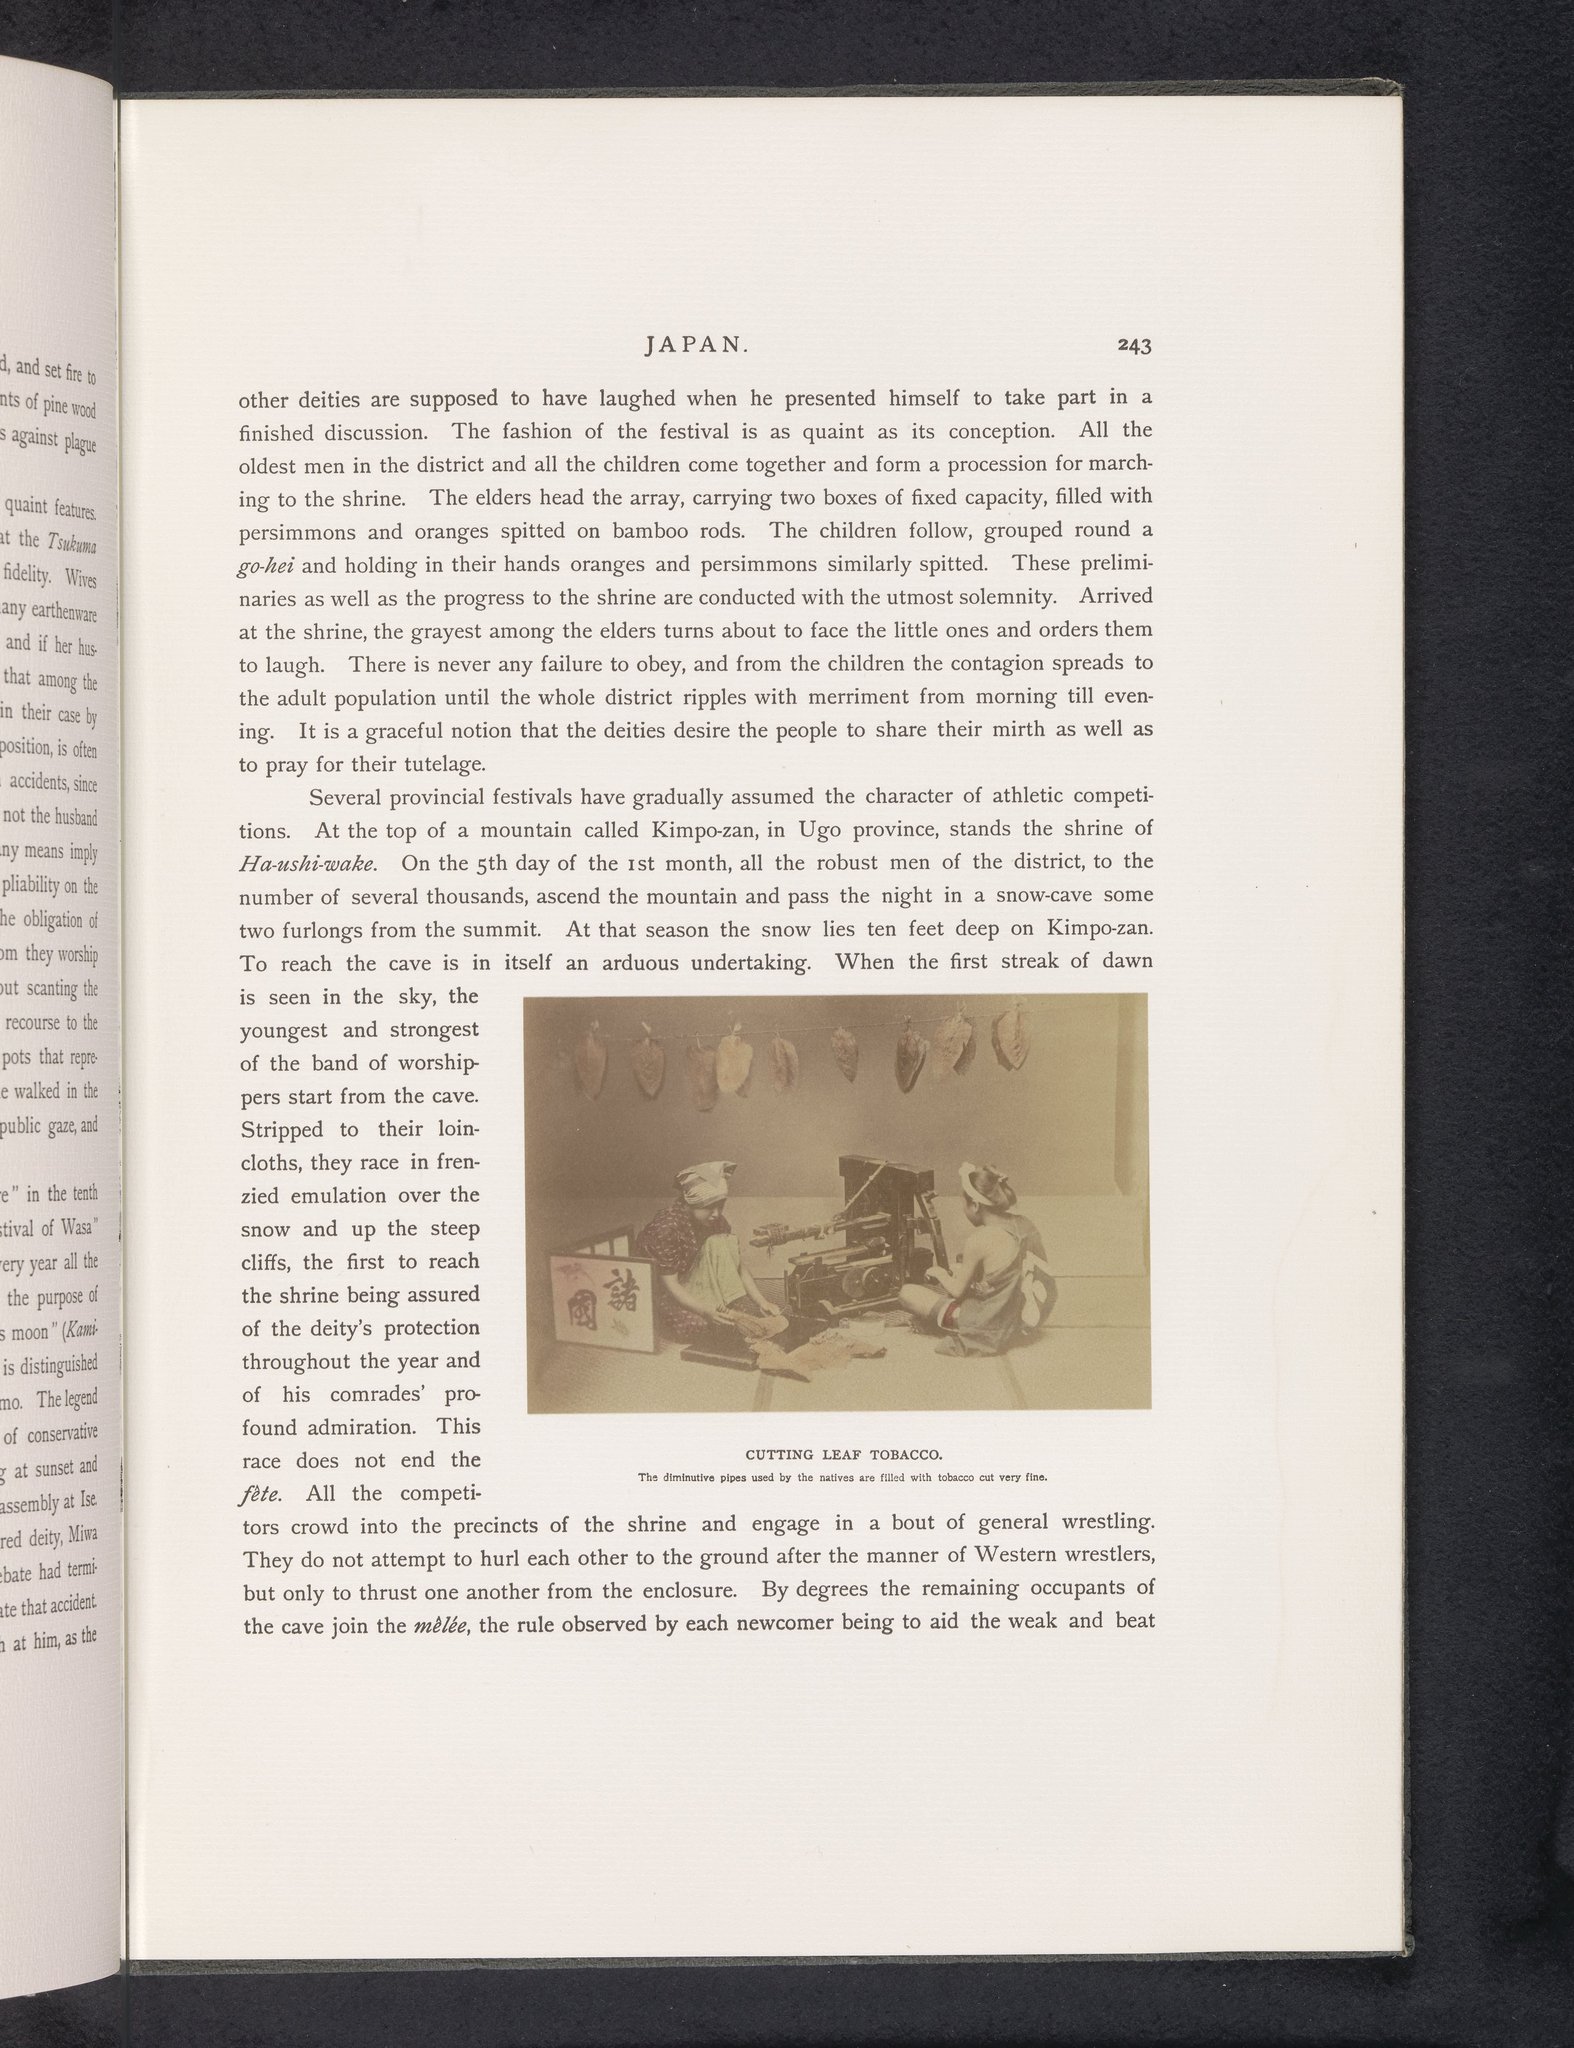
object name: page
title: Cutting leaf tobacco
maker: Anonymous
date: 1887-1897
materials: photographic support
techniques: albumen print, hand coloring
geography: japan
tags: adolescent, young woman, maiden, interior ~ representation of a building, tobacco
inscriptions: inscription: ‘The diminutive pipes used by the natives are filled with tobacco cut very fine.’